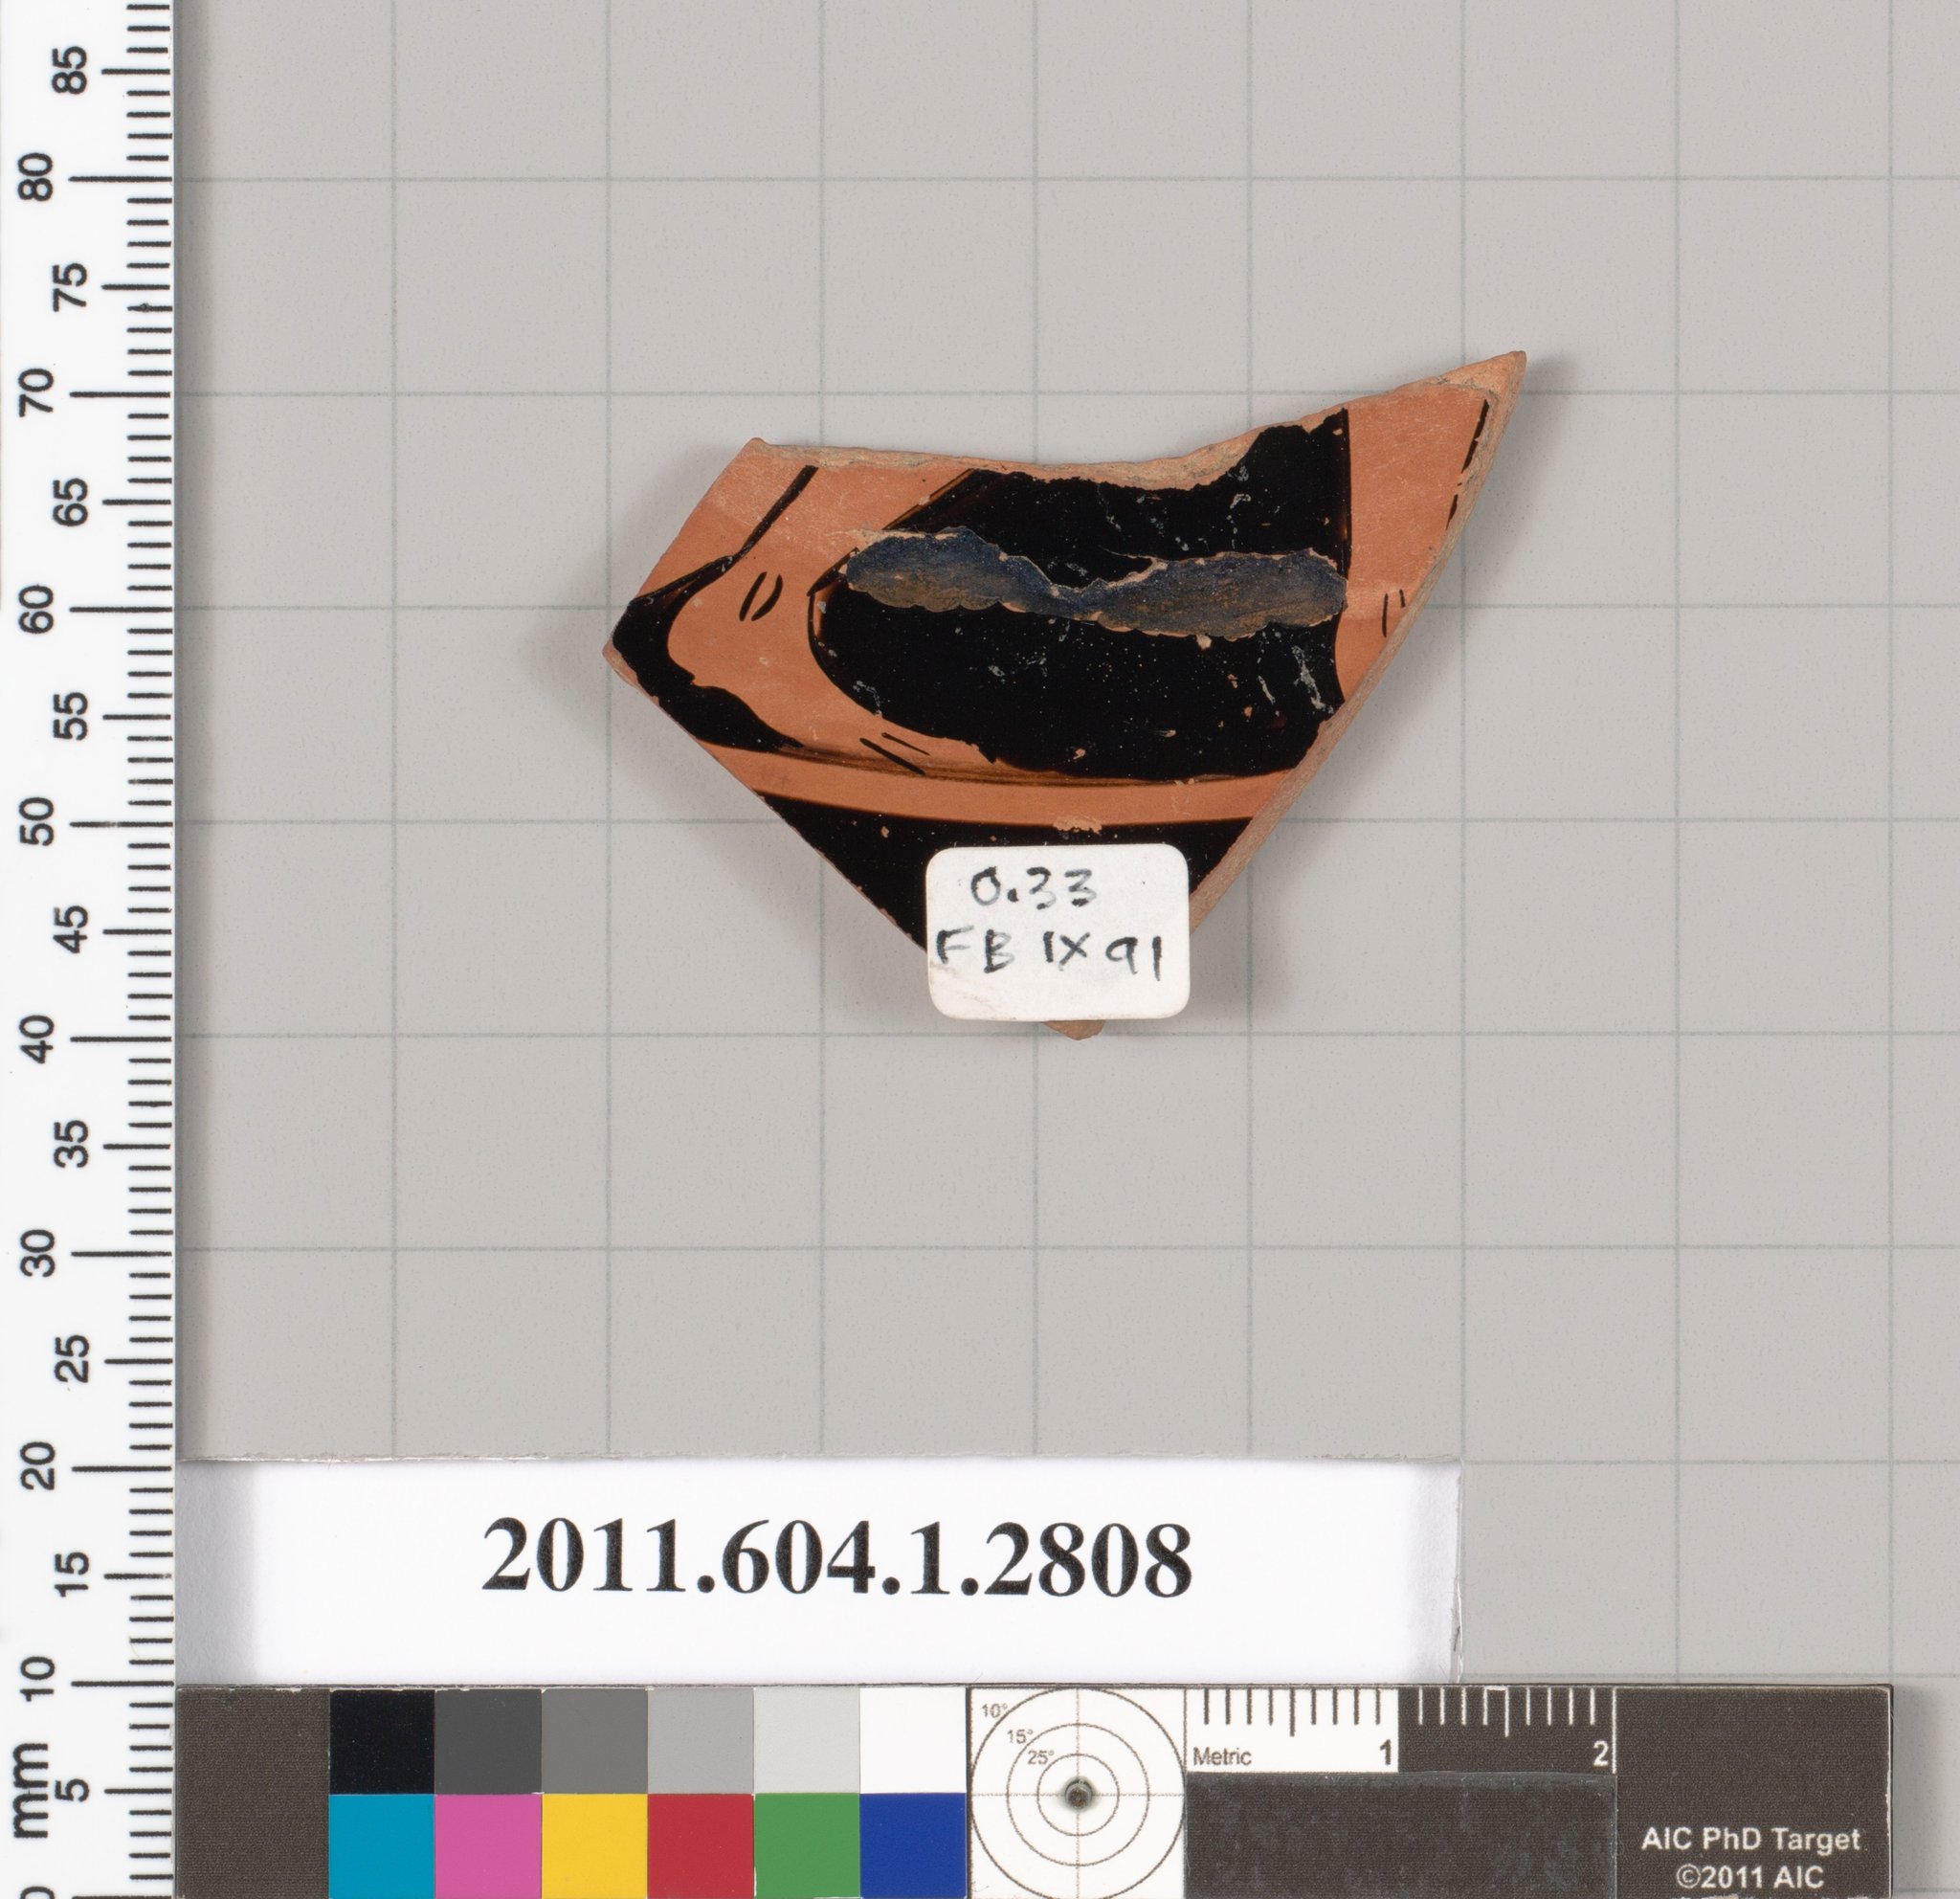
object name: kylix fragment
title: Terracotta fragment of a kylix (drinking cup)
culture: greek, attic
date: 520-500 BCE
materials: terracotta